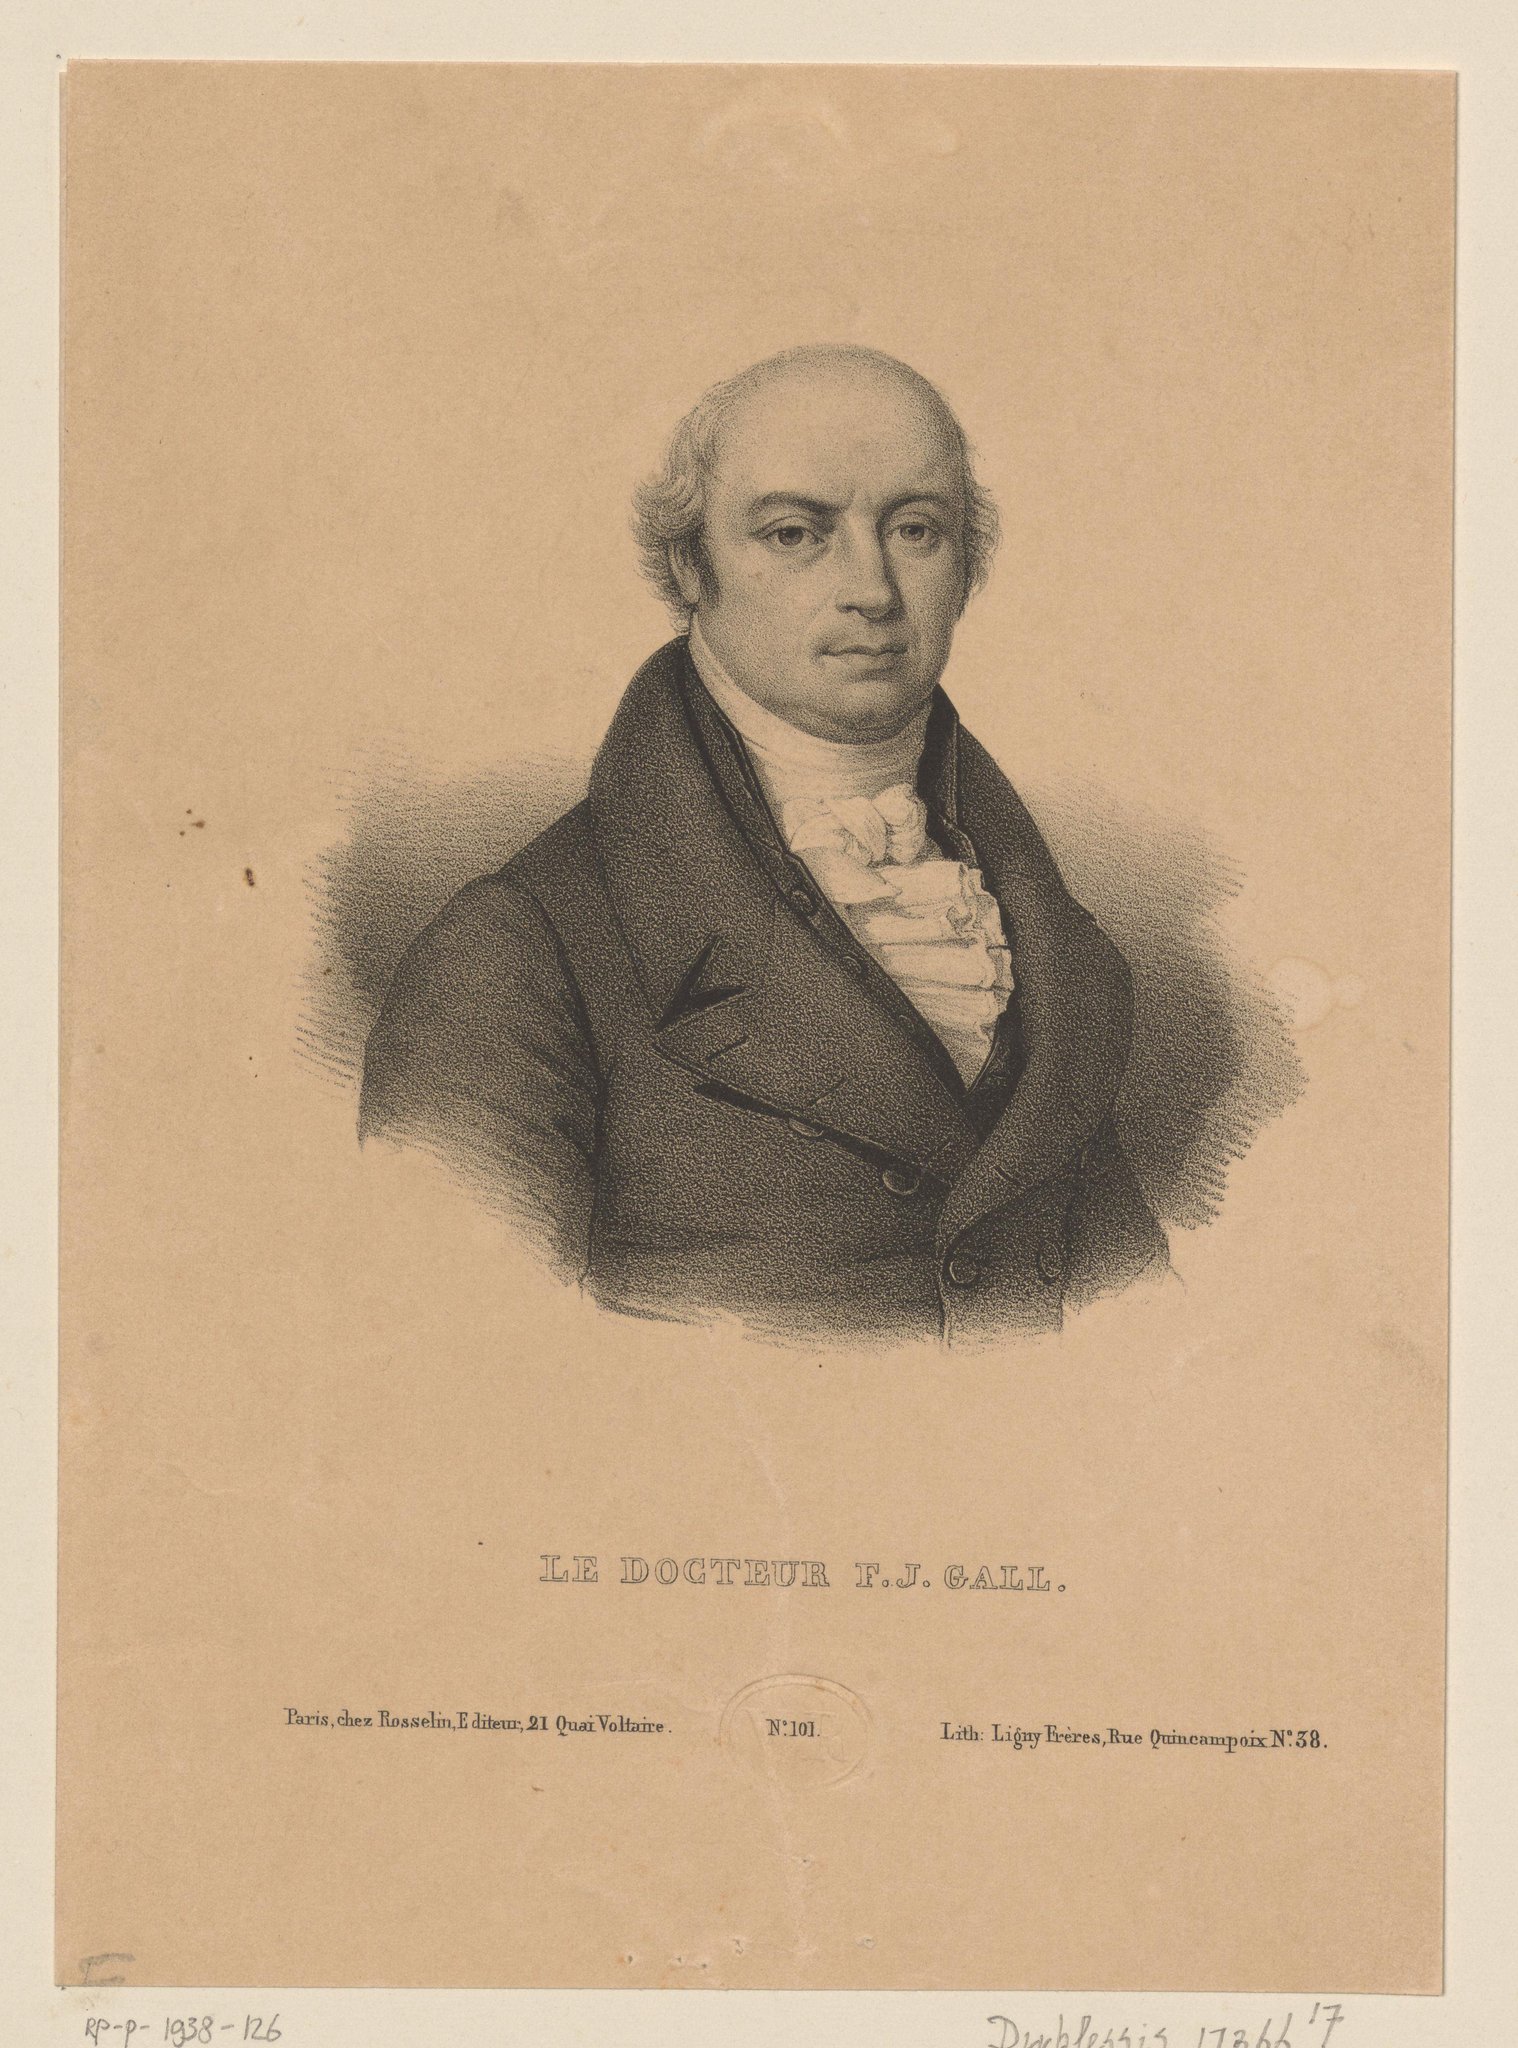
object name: print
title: Portret van Franz Joseph Gall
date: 1830-1861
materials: paper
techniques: lithograph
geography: paris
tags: historical persons, physician, doctor (+ portrait of scholar, scientist)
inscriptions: collector's mark: Lugt 3693, collector's mark: Lugt 2228